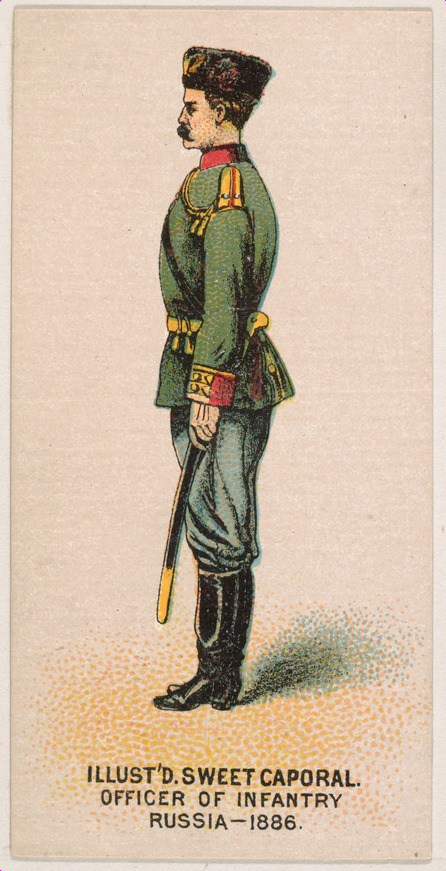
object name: print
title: Officer of Infantry, Russia, 1886, from the Military Series (N224) issued by Kinney Tobacco Company to promote Sweet Caporal Cigarettes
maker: kinney brothers tobacco company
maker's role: publisher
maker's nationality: american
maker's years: 1869-2011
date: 1888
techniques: color lithograph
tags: soldiers,men,profiles